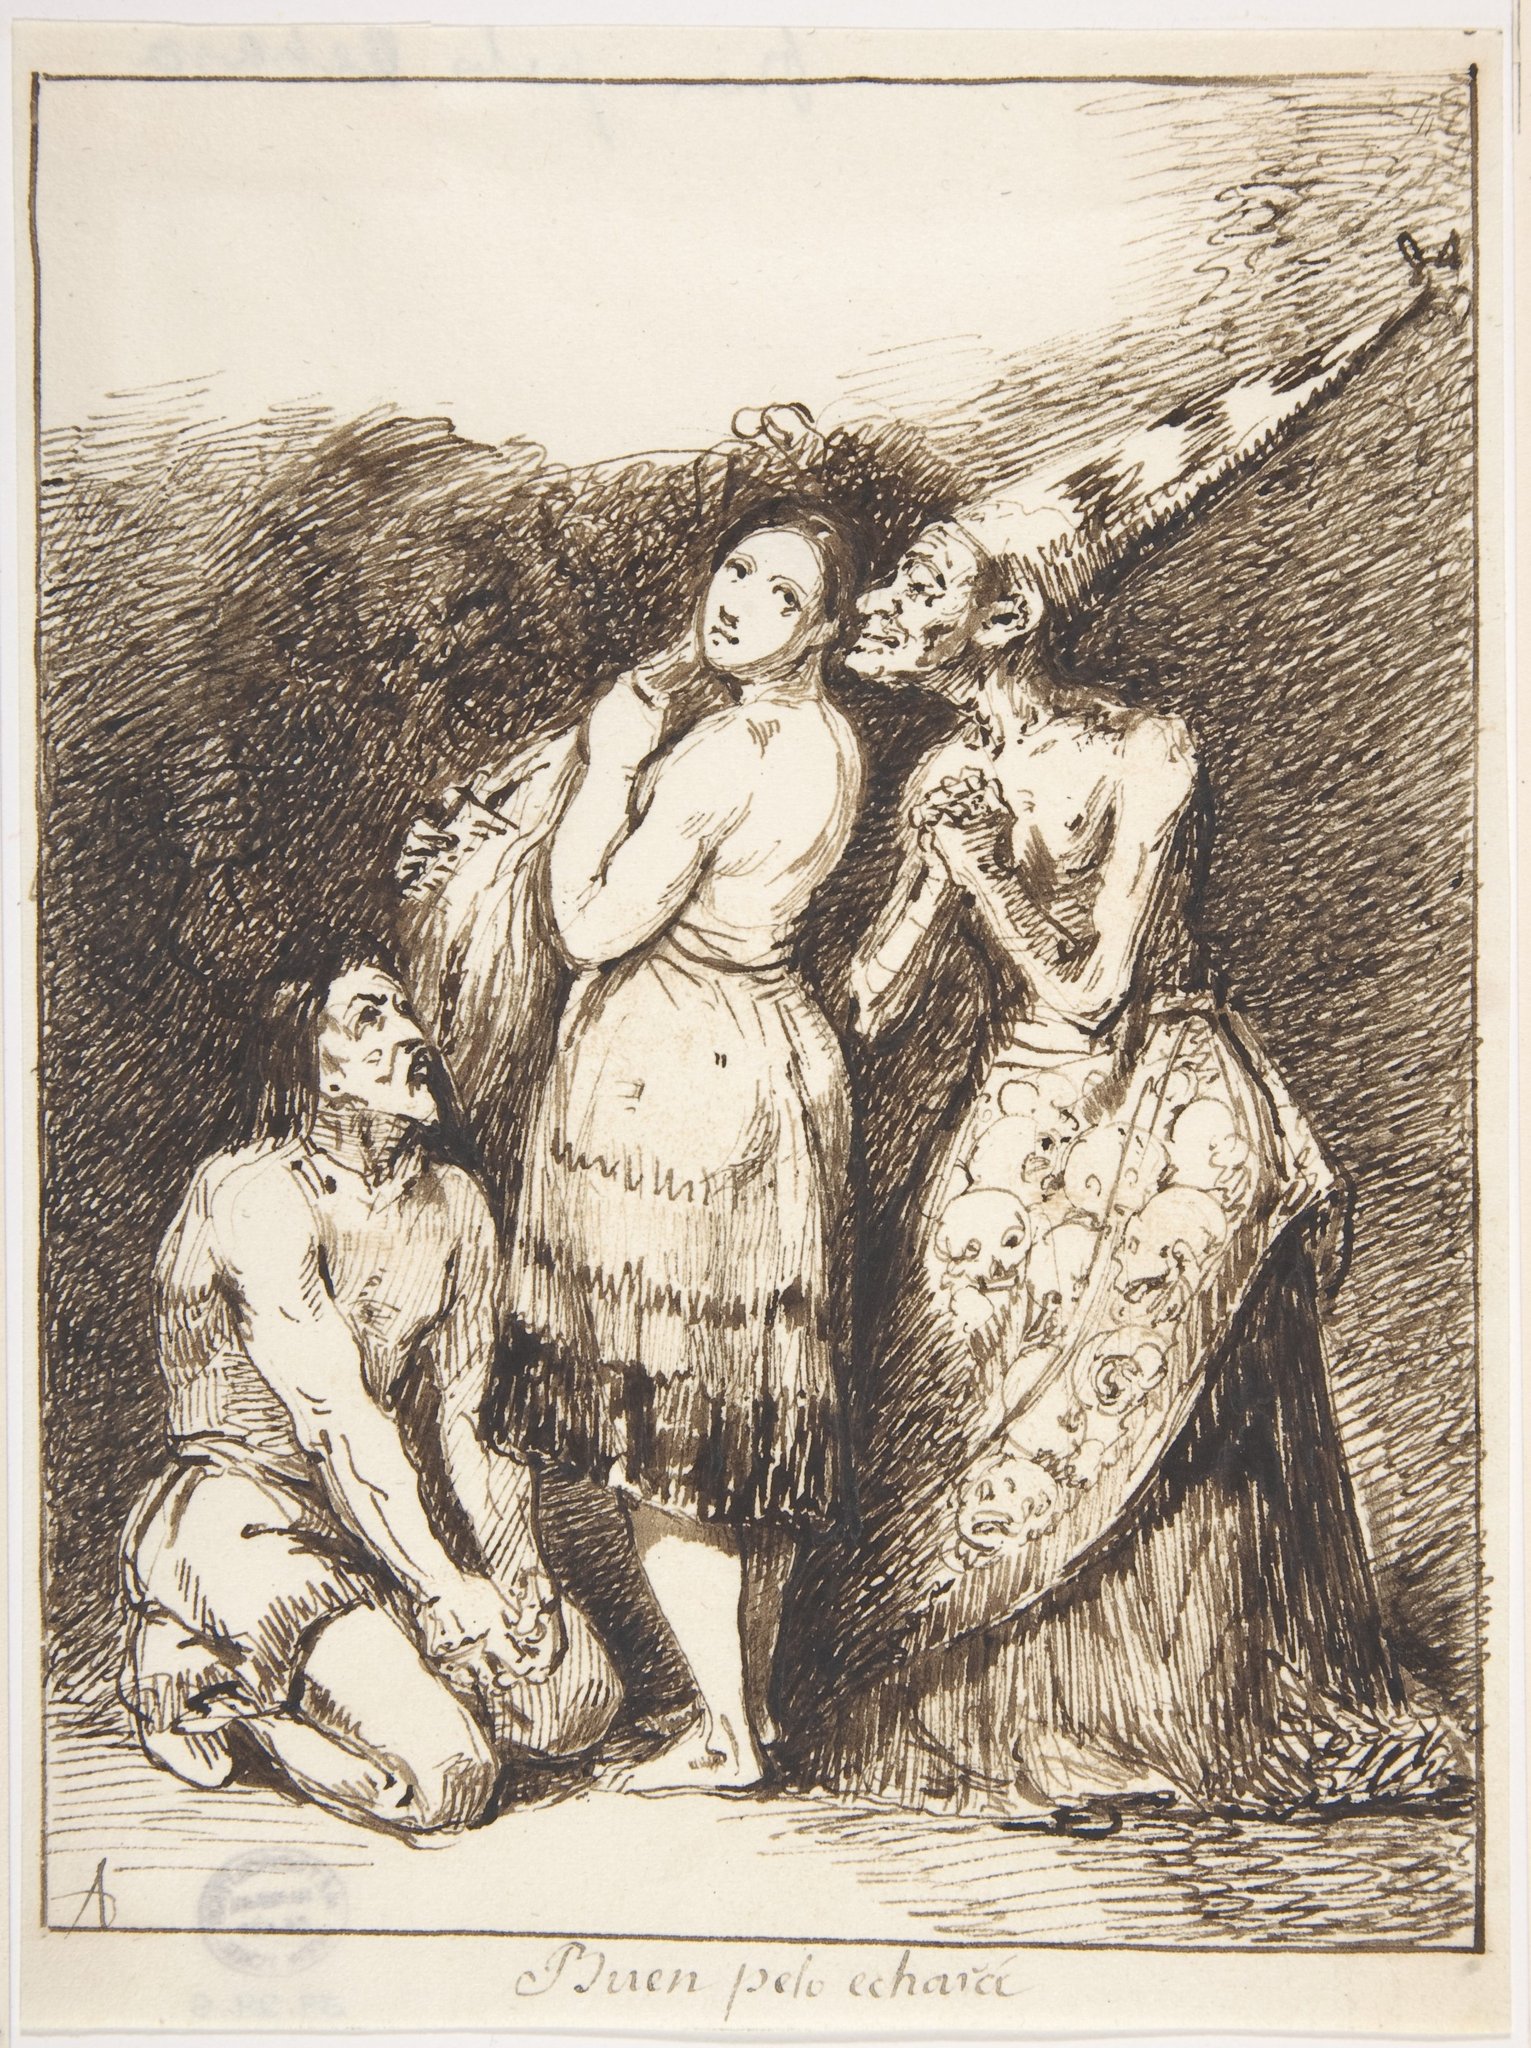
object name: drawing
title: They'll Get Their Desserts (Buen pelo echará)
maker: leonardo alenza y nieto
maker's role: artist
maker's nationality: spanish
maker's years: 1807-1845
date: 1807-1845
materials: ink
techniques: pen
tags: men,women